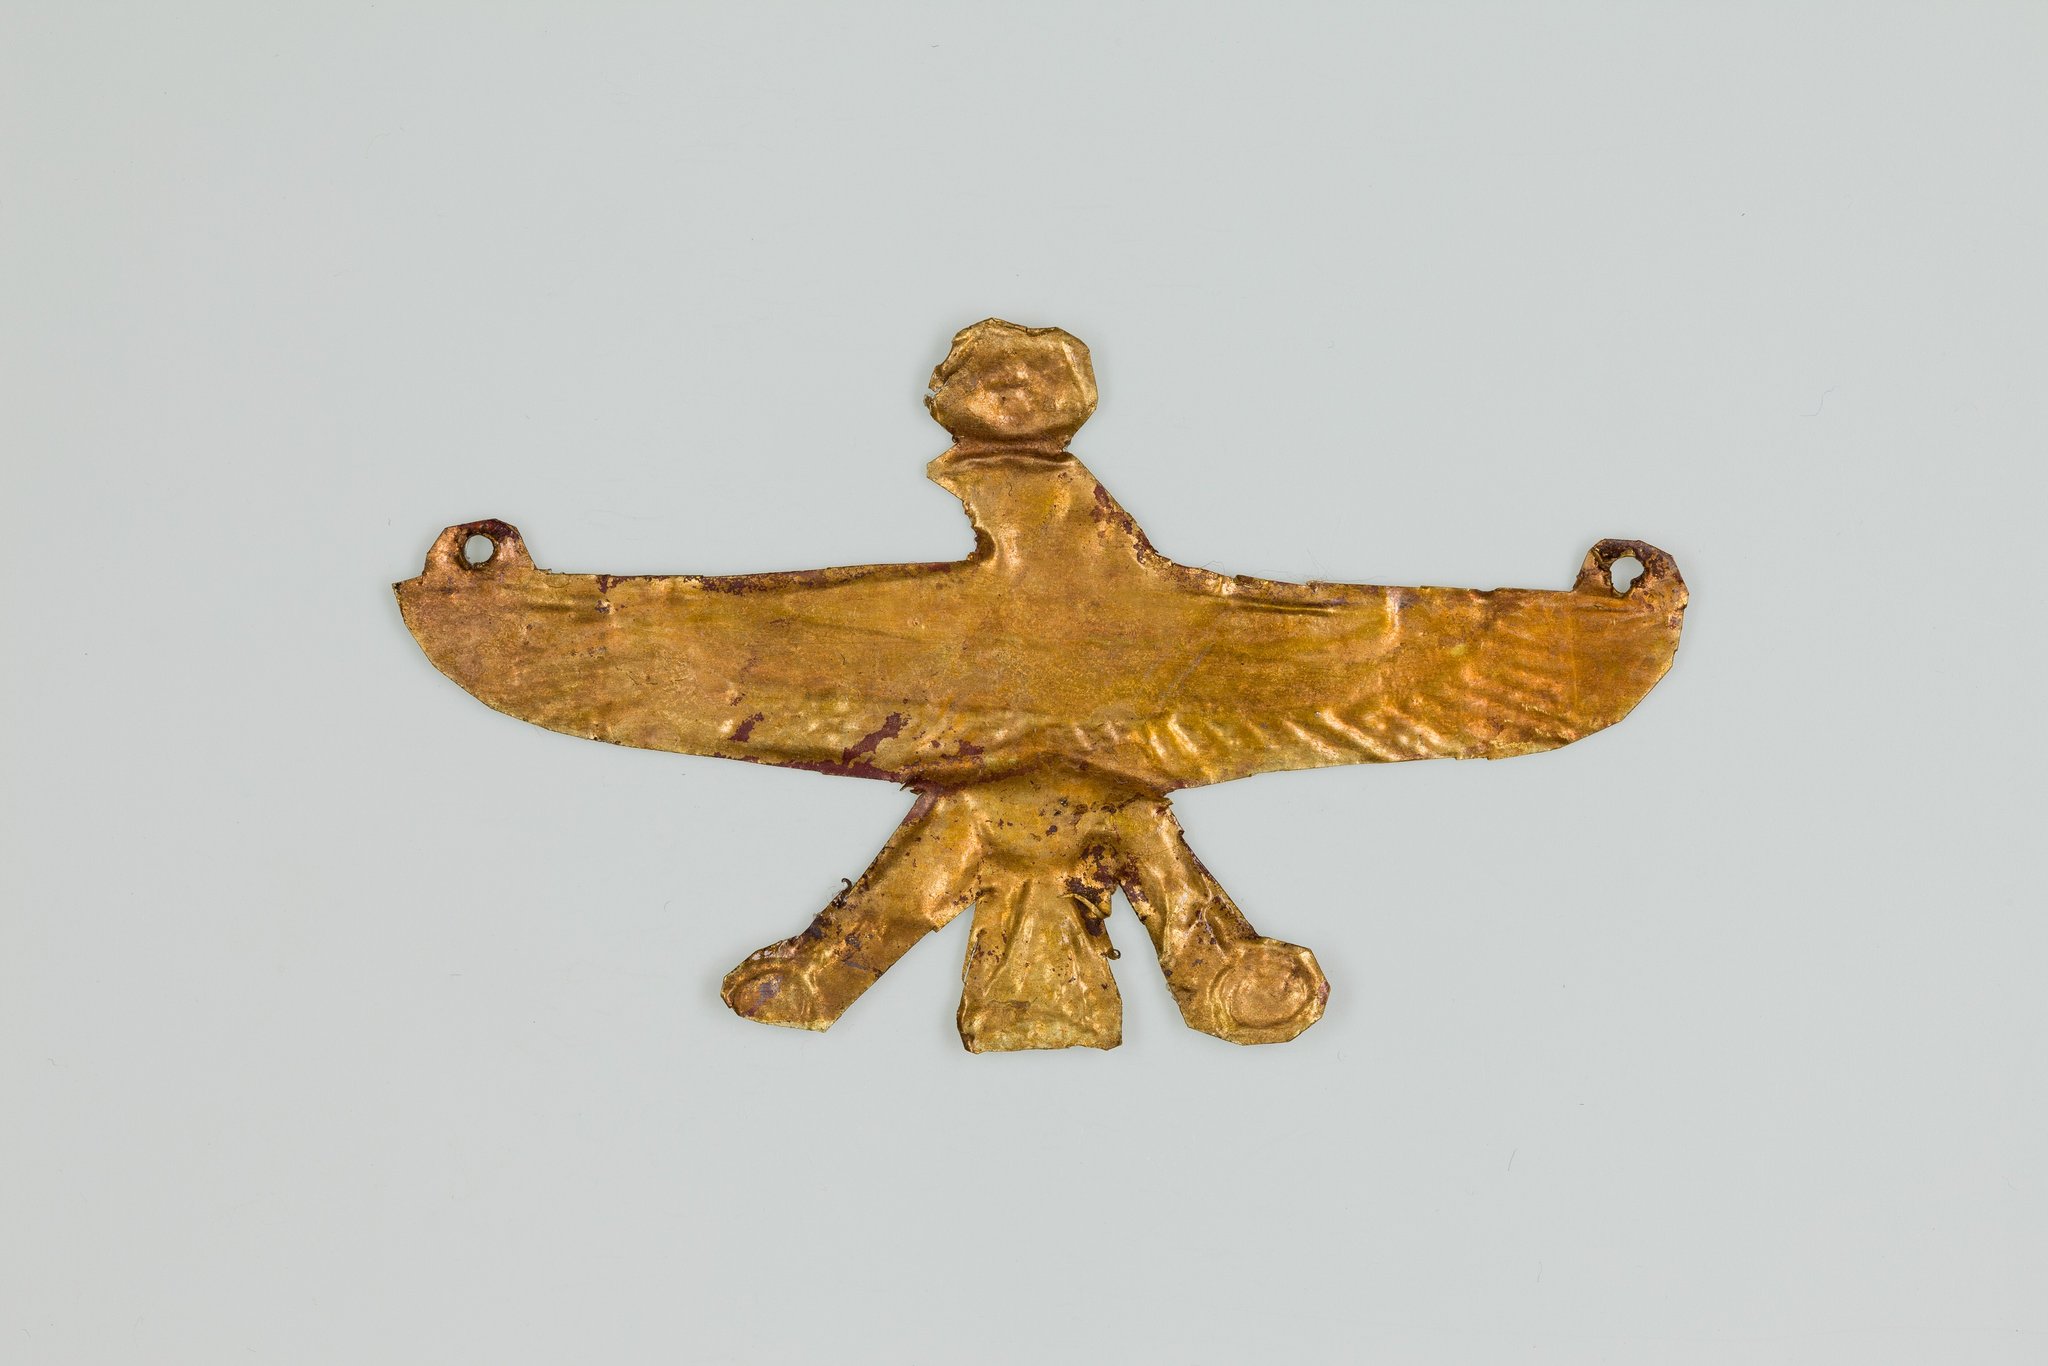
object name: amulet, fying falcon, sundisk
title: Falcon amulet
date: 664-380 BCE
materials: gold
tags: falcons